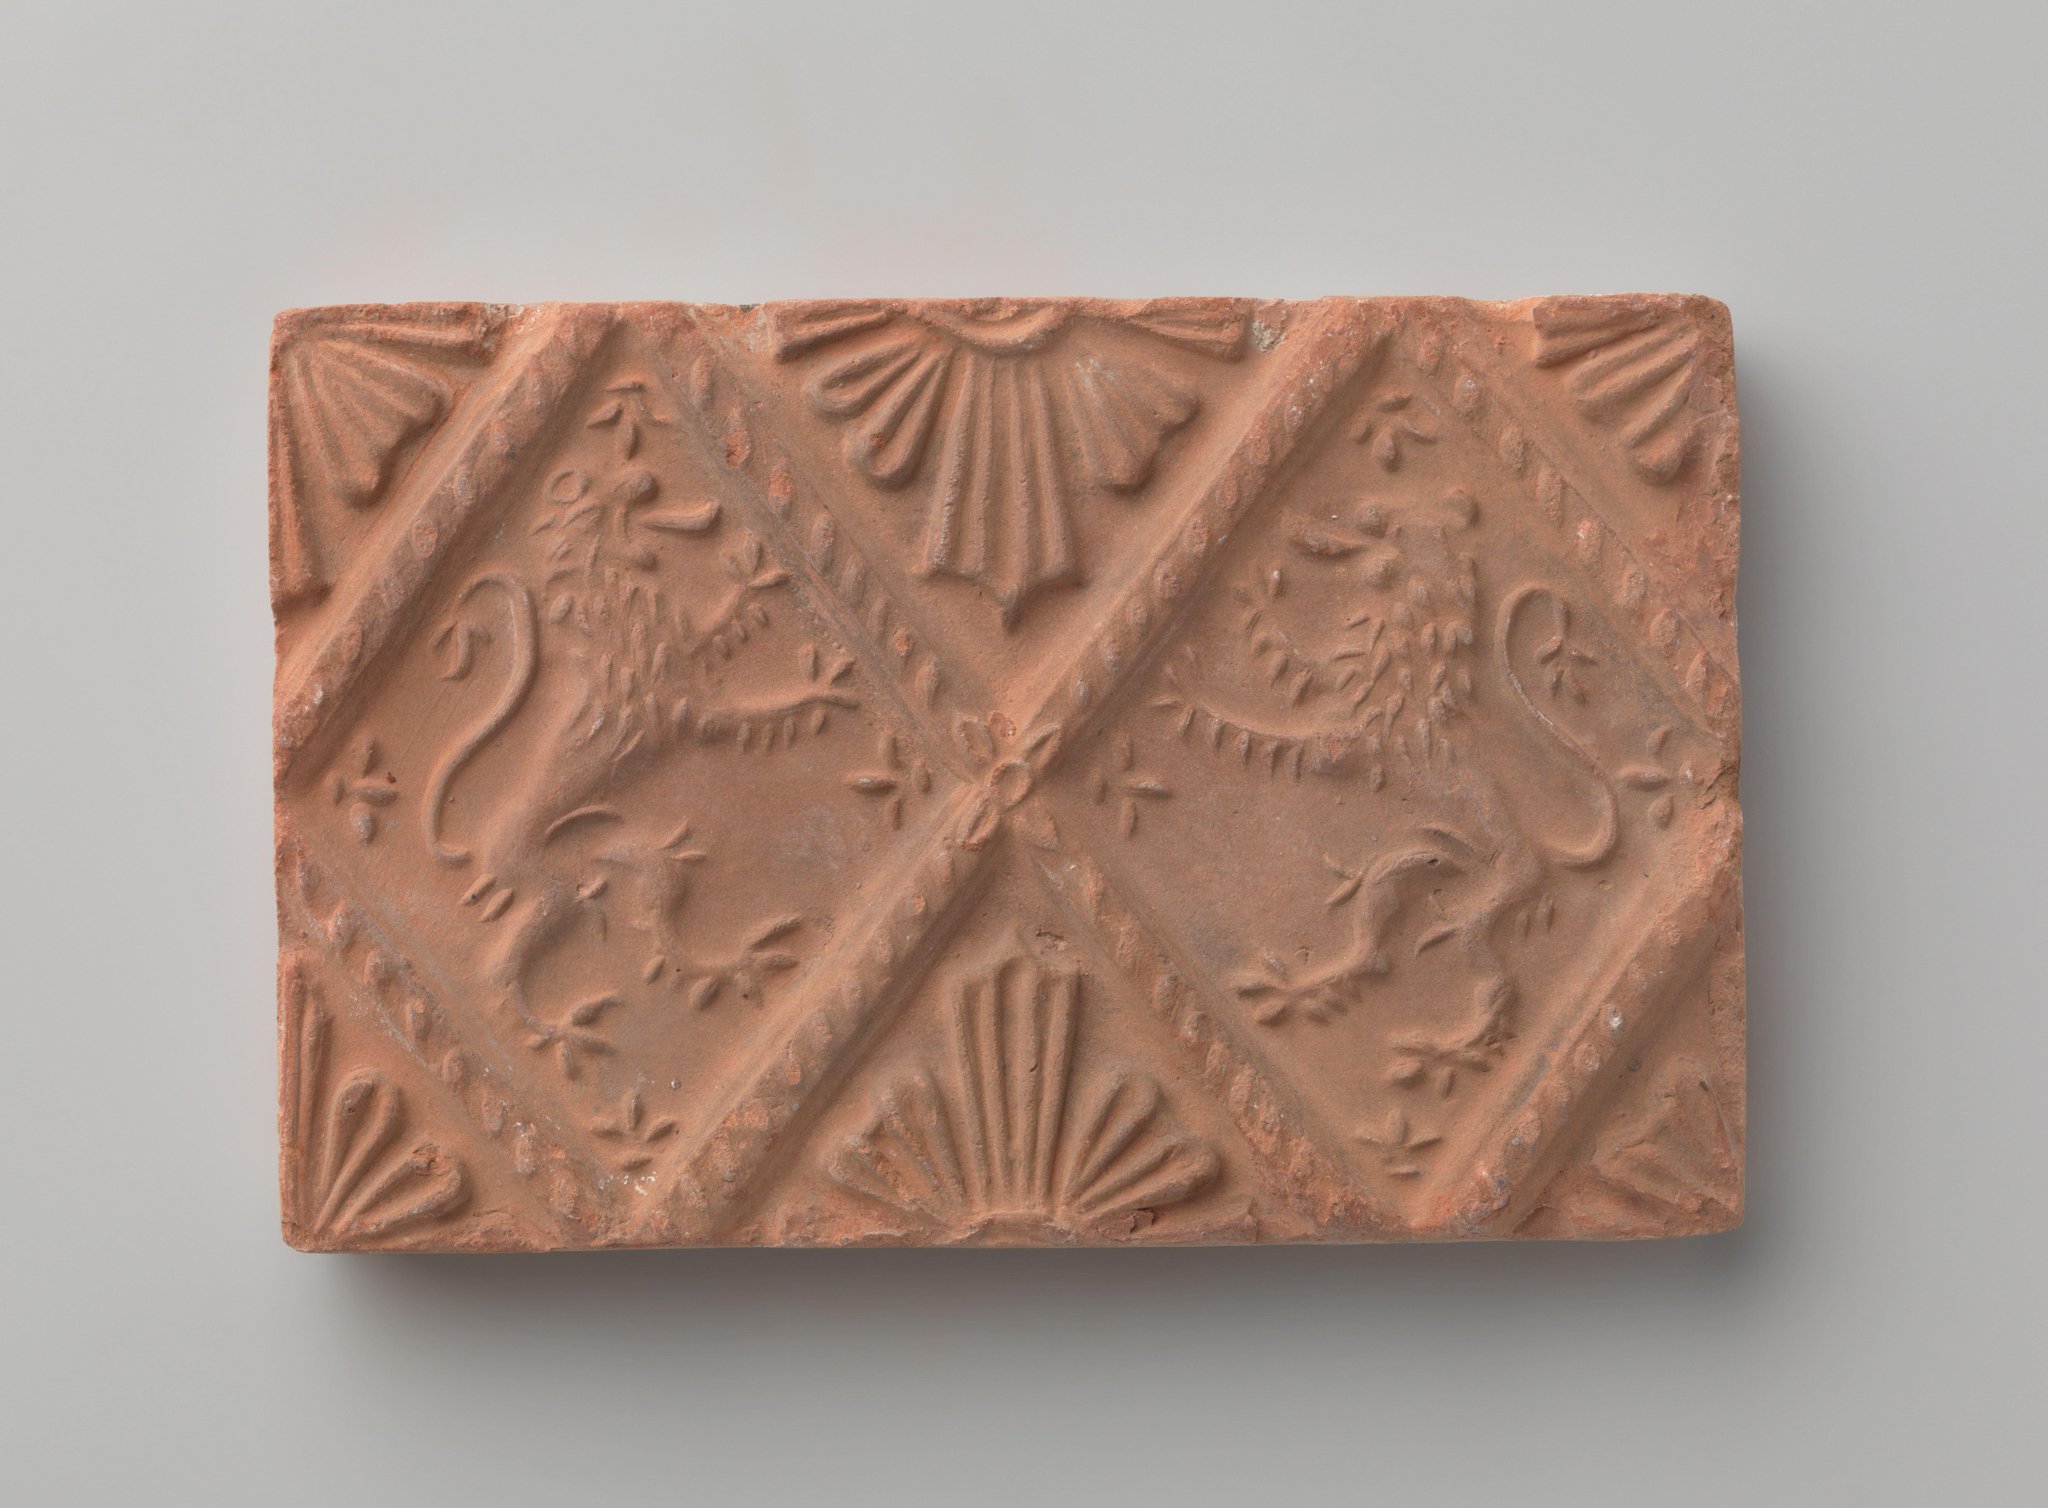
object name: hearthstone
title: Haardsteen met voorstelling van twee klimmende leeuwen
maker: Anonymous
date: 1875-1900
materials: earthenware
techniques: printing, firing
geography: netherlands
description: Haardsteen met voorstelling van twee klimmende leeuwen, geplaatst in geprofileerde ruit. De halve ruiten aan de boven- en onderkant zijn opgevuld met stermotief.